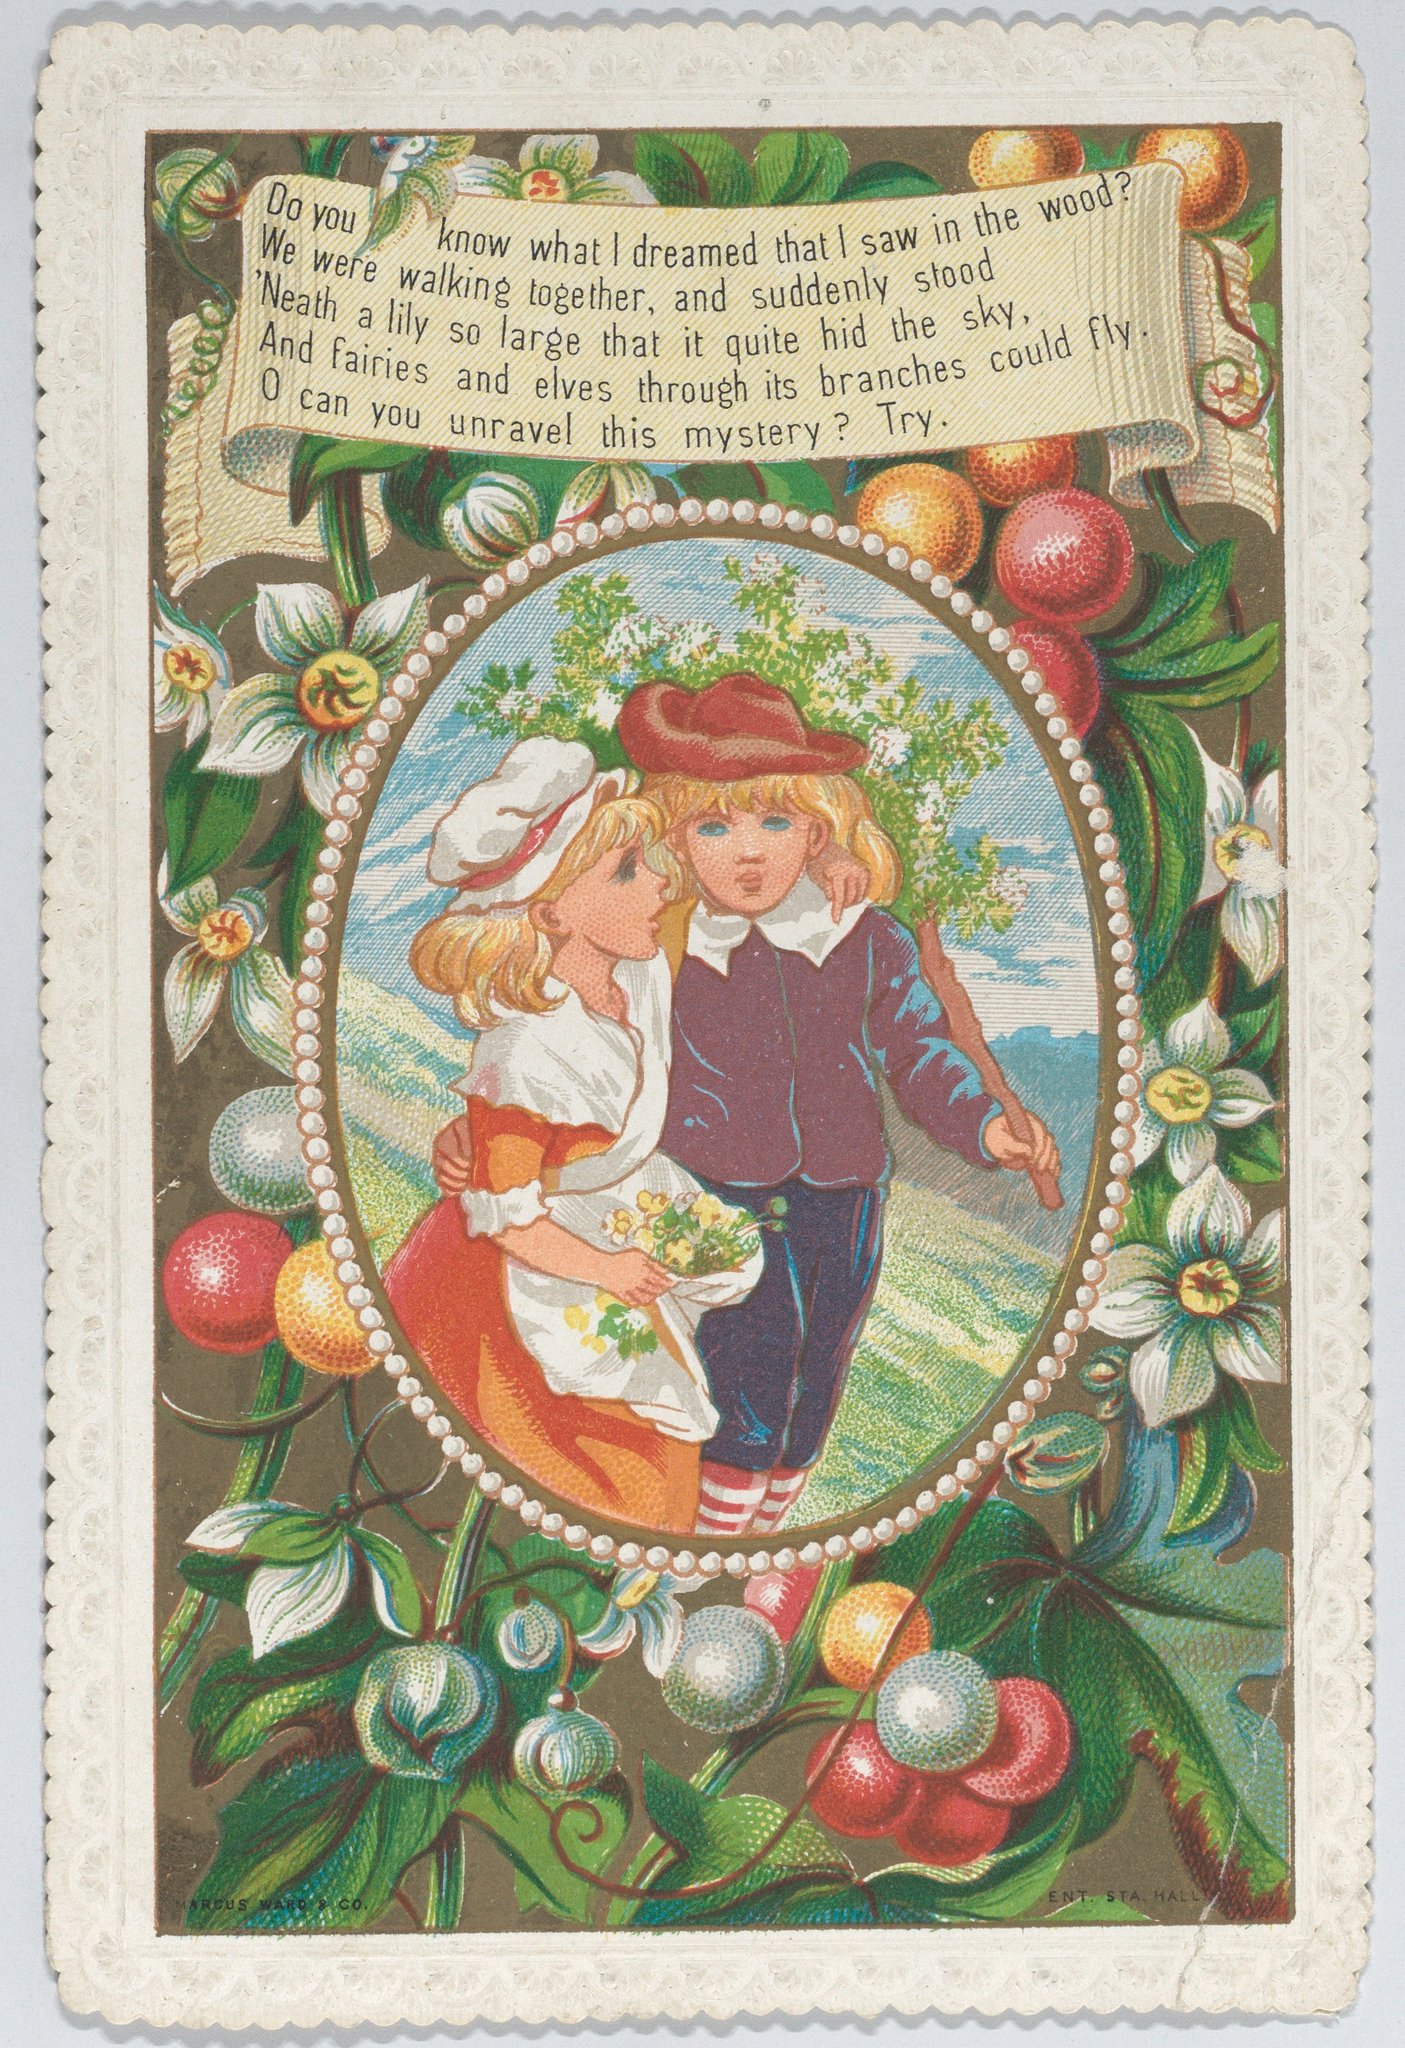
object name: valentine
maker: kate greenaway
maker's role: artist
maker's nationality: british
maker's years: 1846-1901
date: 1874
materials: gold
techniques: chromolithography, embossing, lithograph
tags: poetry,boys,girls